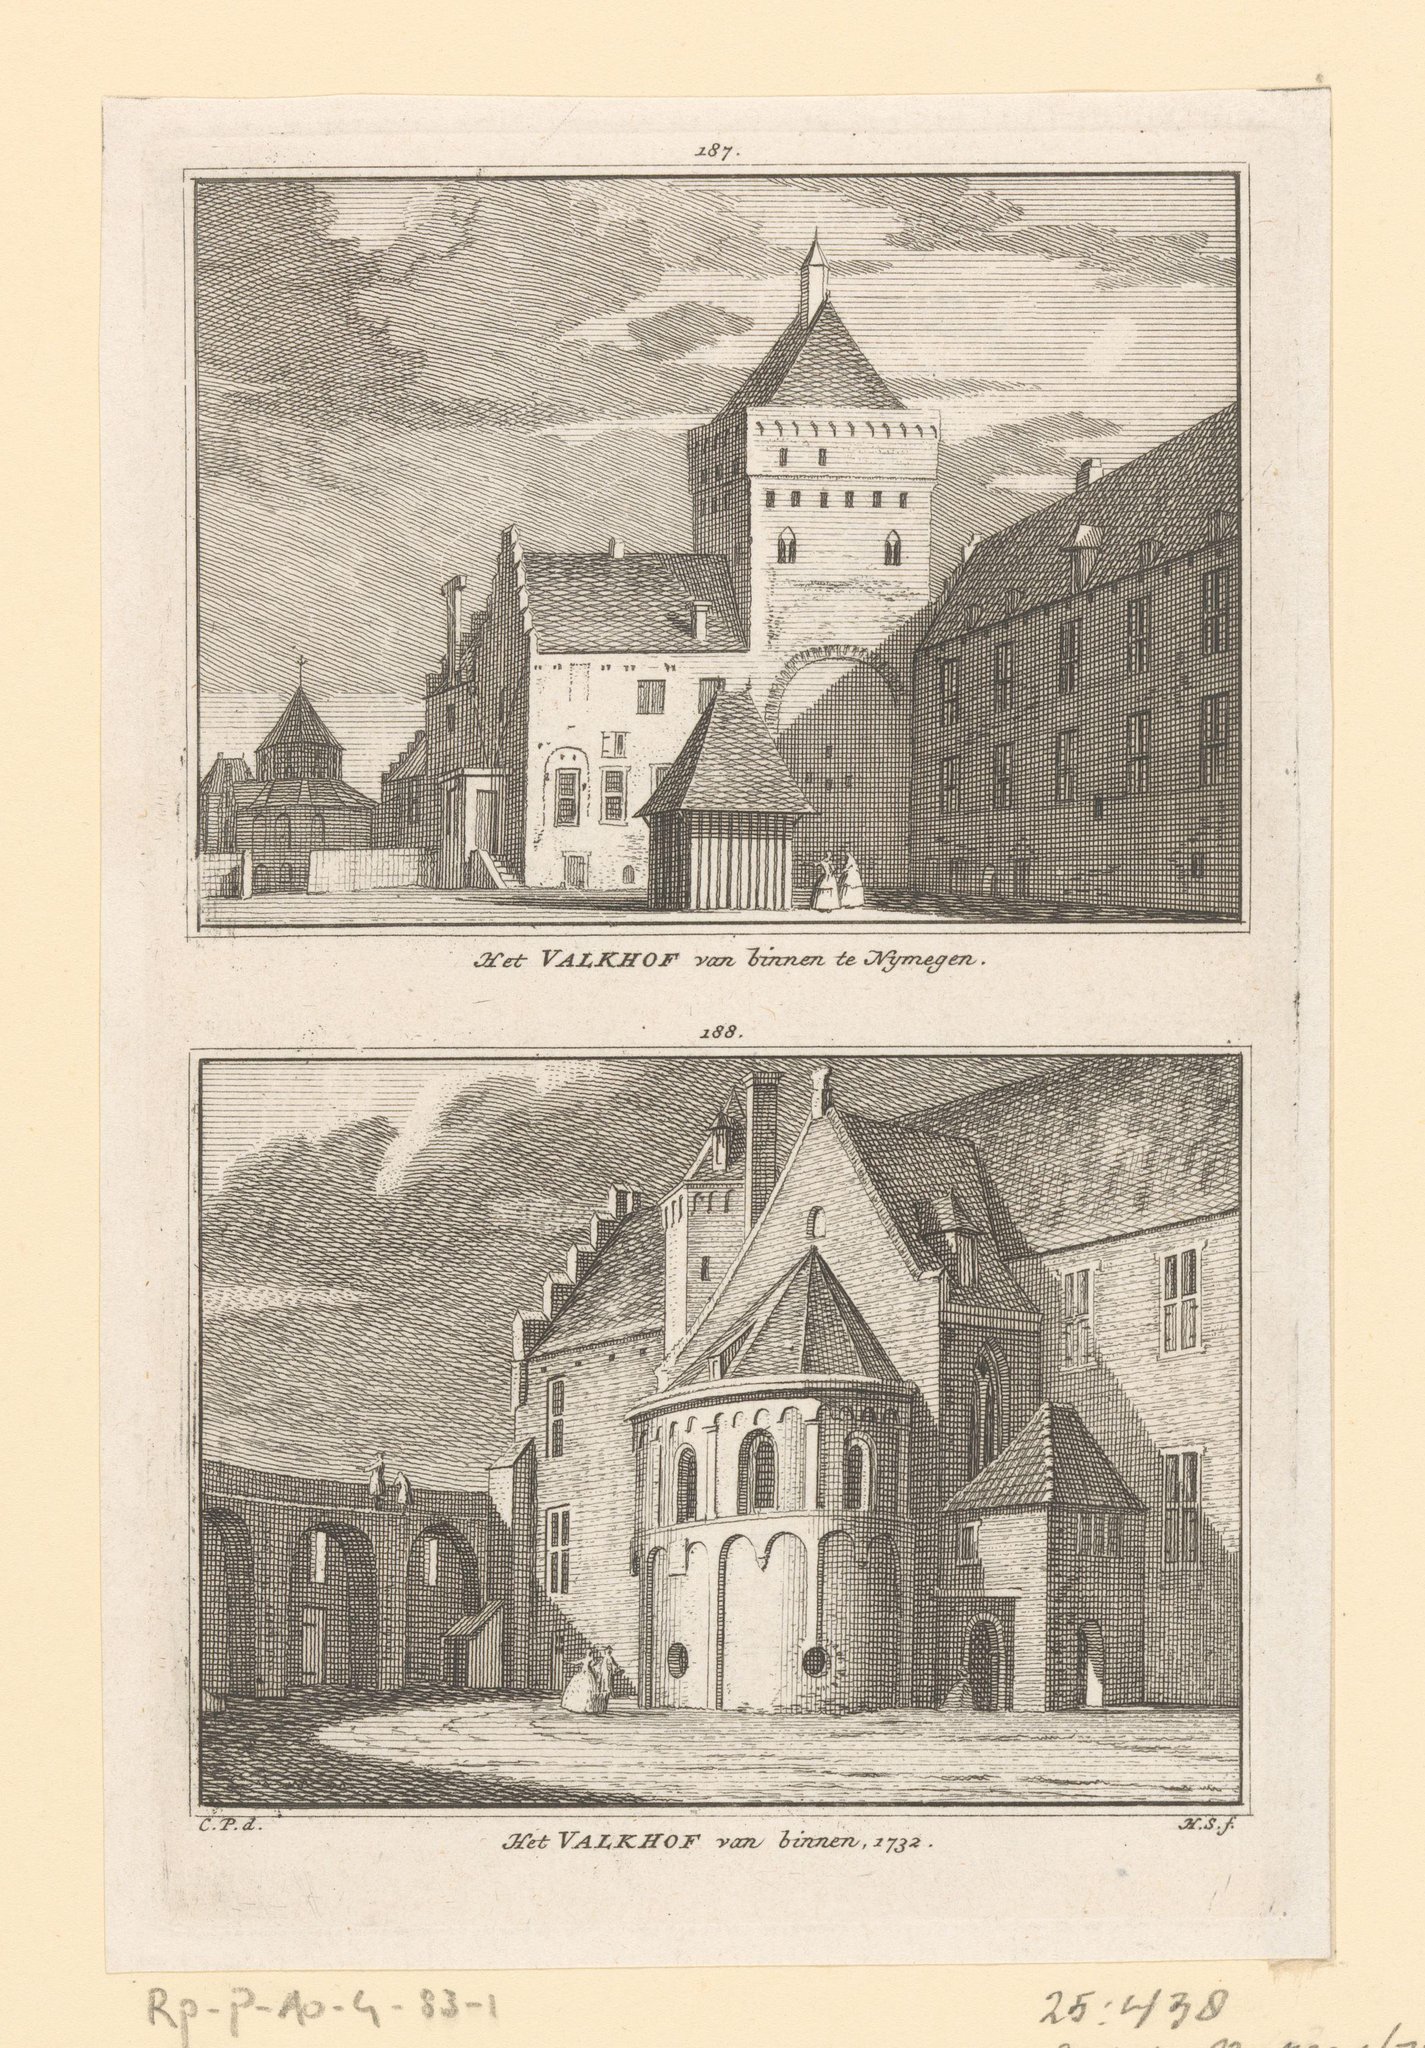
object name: print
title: Het Valkhof van binnen te Nymegen / Het Valkhof van binnen, 1732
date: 1746-1792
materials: paper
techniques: etching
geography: haarlem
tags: castle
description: Prent ook gebruikt in: Het verheerlykt Nederland of kabinet van hedendaagsche gezigten van steden, dorpen (…). 9 delen. Amsterdam: Isaak Tirion en weduwe Isaak Tirion, 1745-1774, dl. 2 (1746), ill. 187-188. Of in: Nederlandsche tafereelen; of eene keurige verzameling van negen honderd fraaije gezigten van steden, dorpen, sloten, oudheden (….). 9 delen. Amsterdam: Jan de Groot, 1792, dl. 2, ill. 187-188.